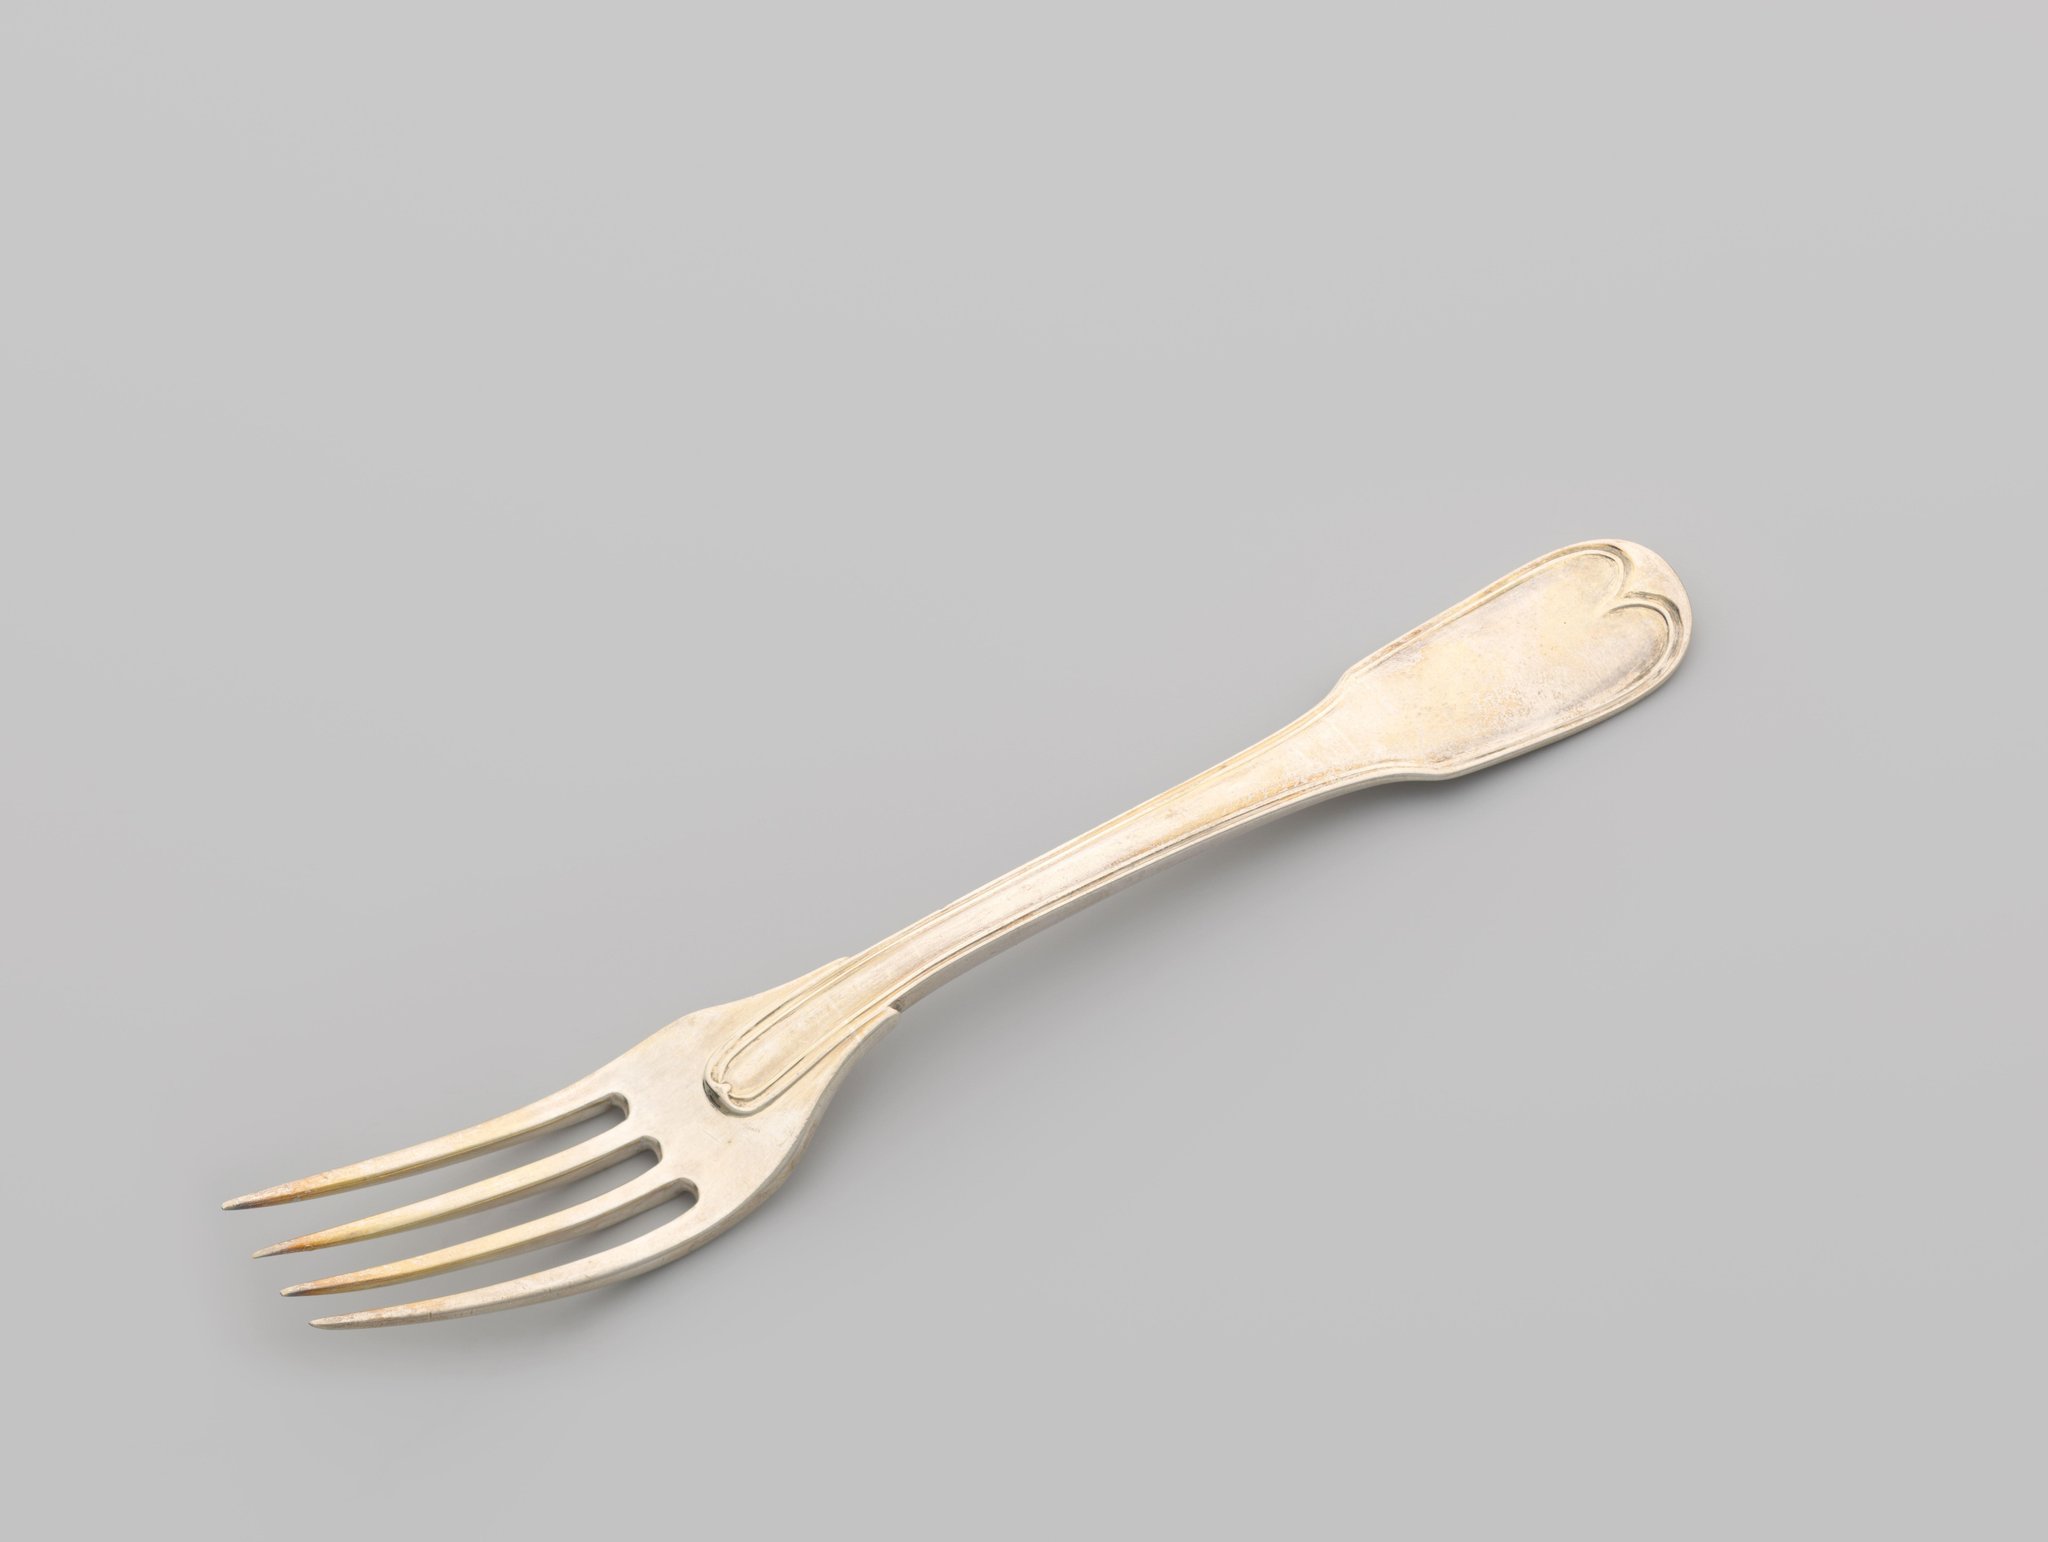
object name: fork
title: Dessertvork met het helmteken Clifford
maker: roelof helweg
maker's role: silversmith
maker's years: 1758-1843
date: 1806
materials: silver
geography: amsterdam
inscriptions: town mark: ‘Amsterdam’, alloy mark: ‘Hollandse leeuw’, date letter: ‘X (=1806)’, maker's mark: ‘RH in ovaal’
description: De viertandige vork is aan zowel boven- als onderzijde door middel van enkel lof verbonden met de platte, gebogen steel, die zich verbreedt naar het spatelvormige uiteinde. Boven- en onderzijde van de steel worden omgeven door een dubbele filetrand, die bij het uiteinde ingezwenkt is. Op de onderzijde van de spatel is het helmteken Clifford gegraveerd.